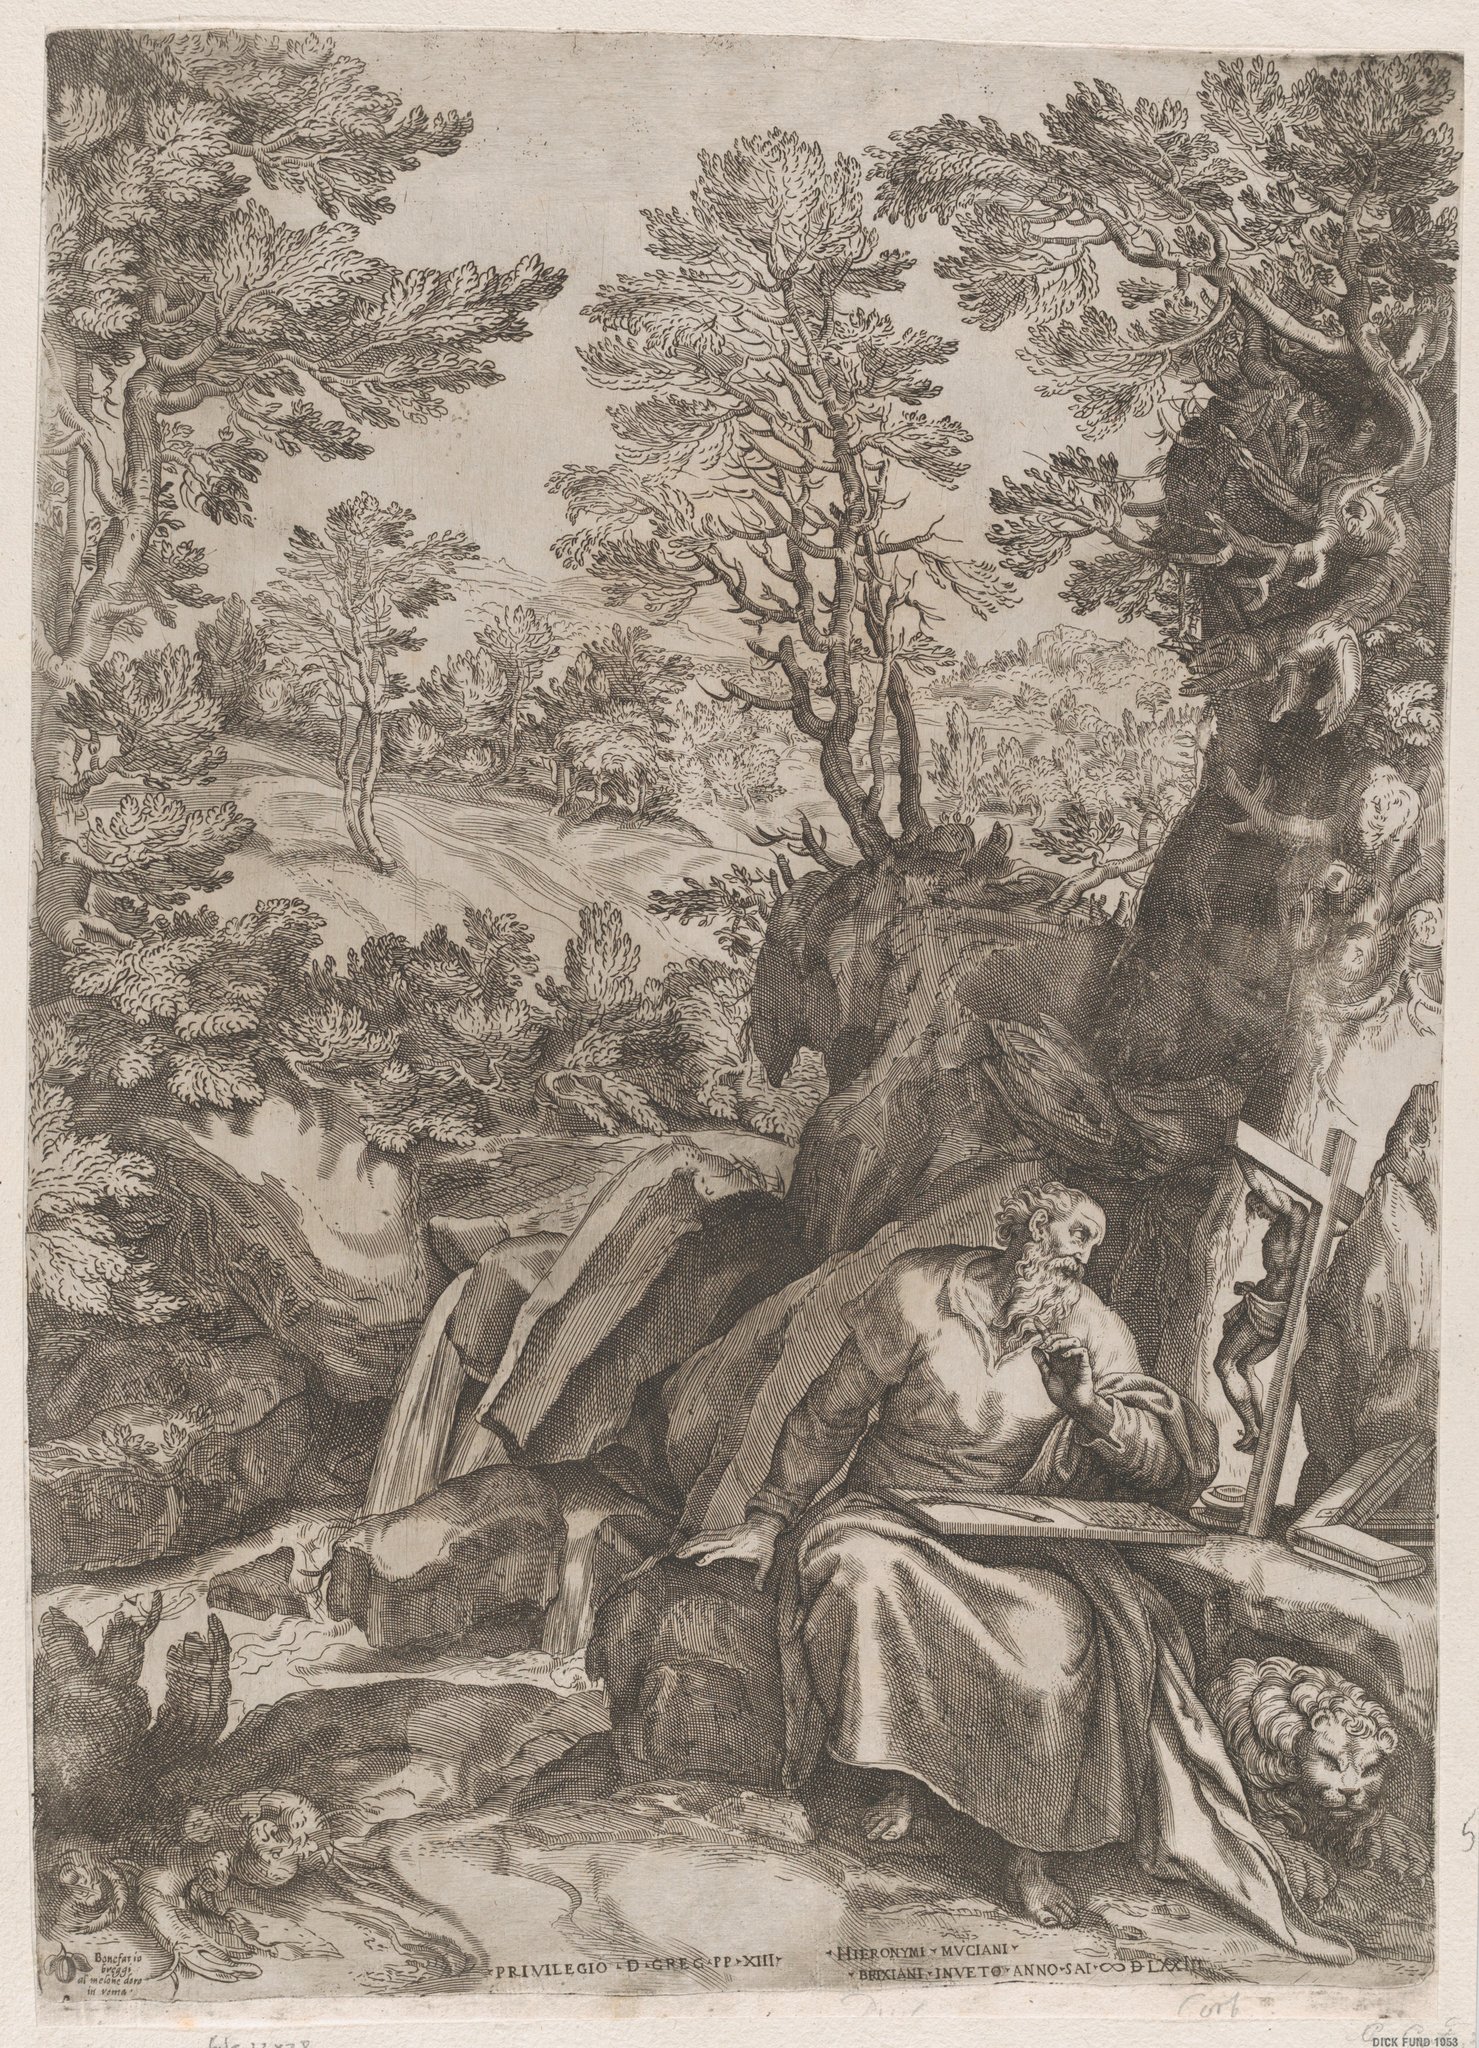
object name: print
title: St Jerome Translating the Bible in the Wilderness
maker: cornelis cort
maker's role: artist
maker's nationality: netherlandish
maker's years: 1533-1578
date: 1573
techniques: engraving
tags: forests,saint jerome,cross,bible